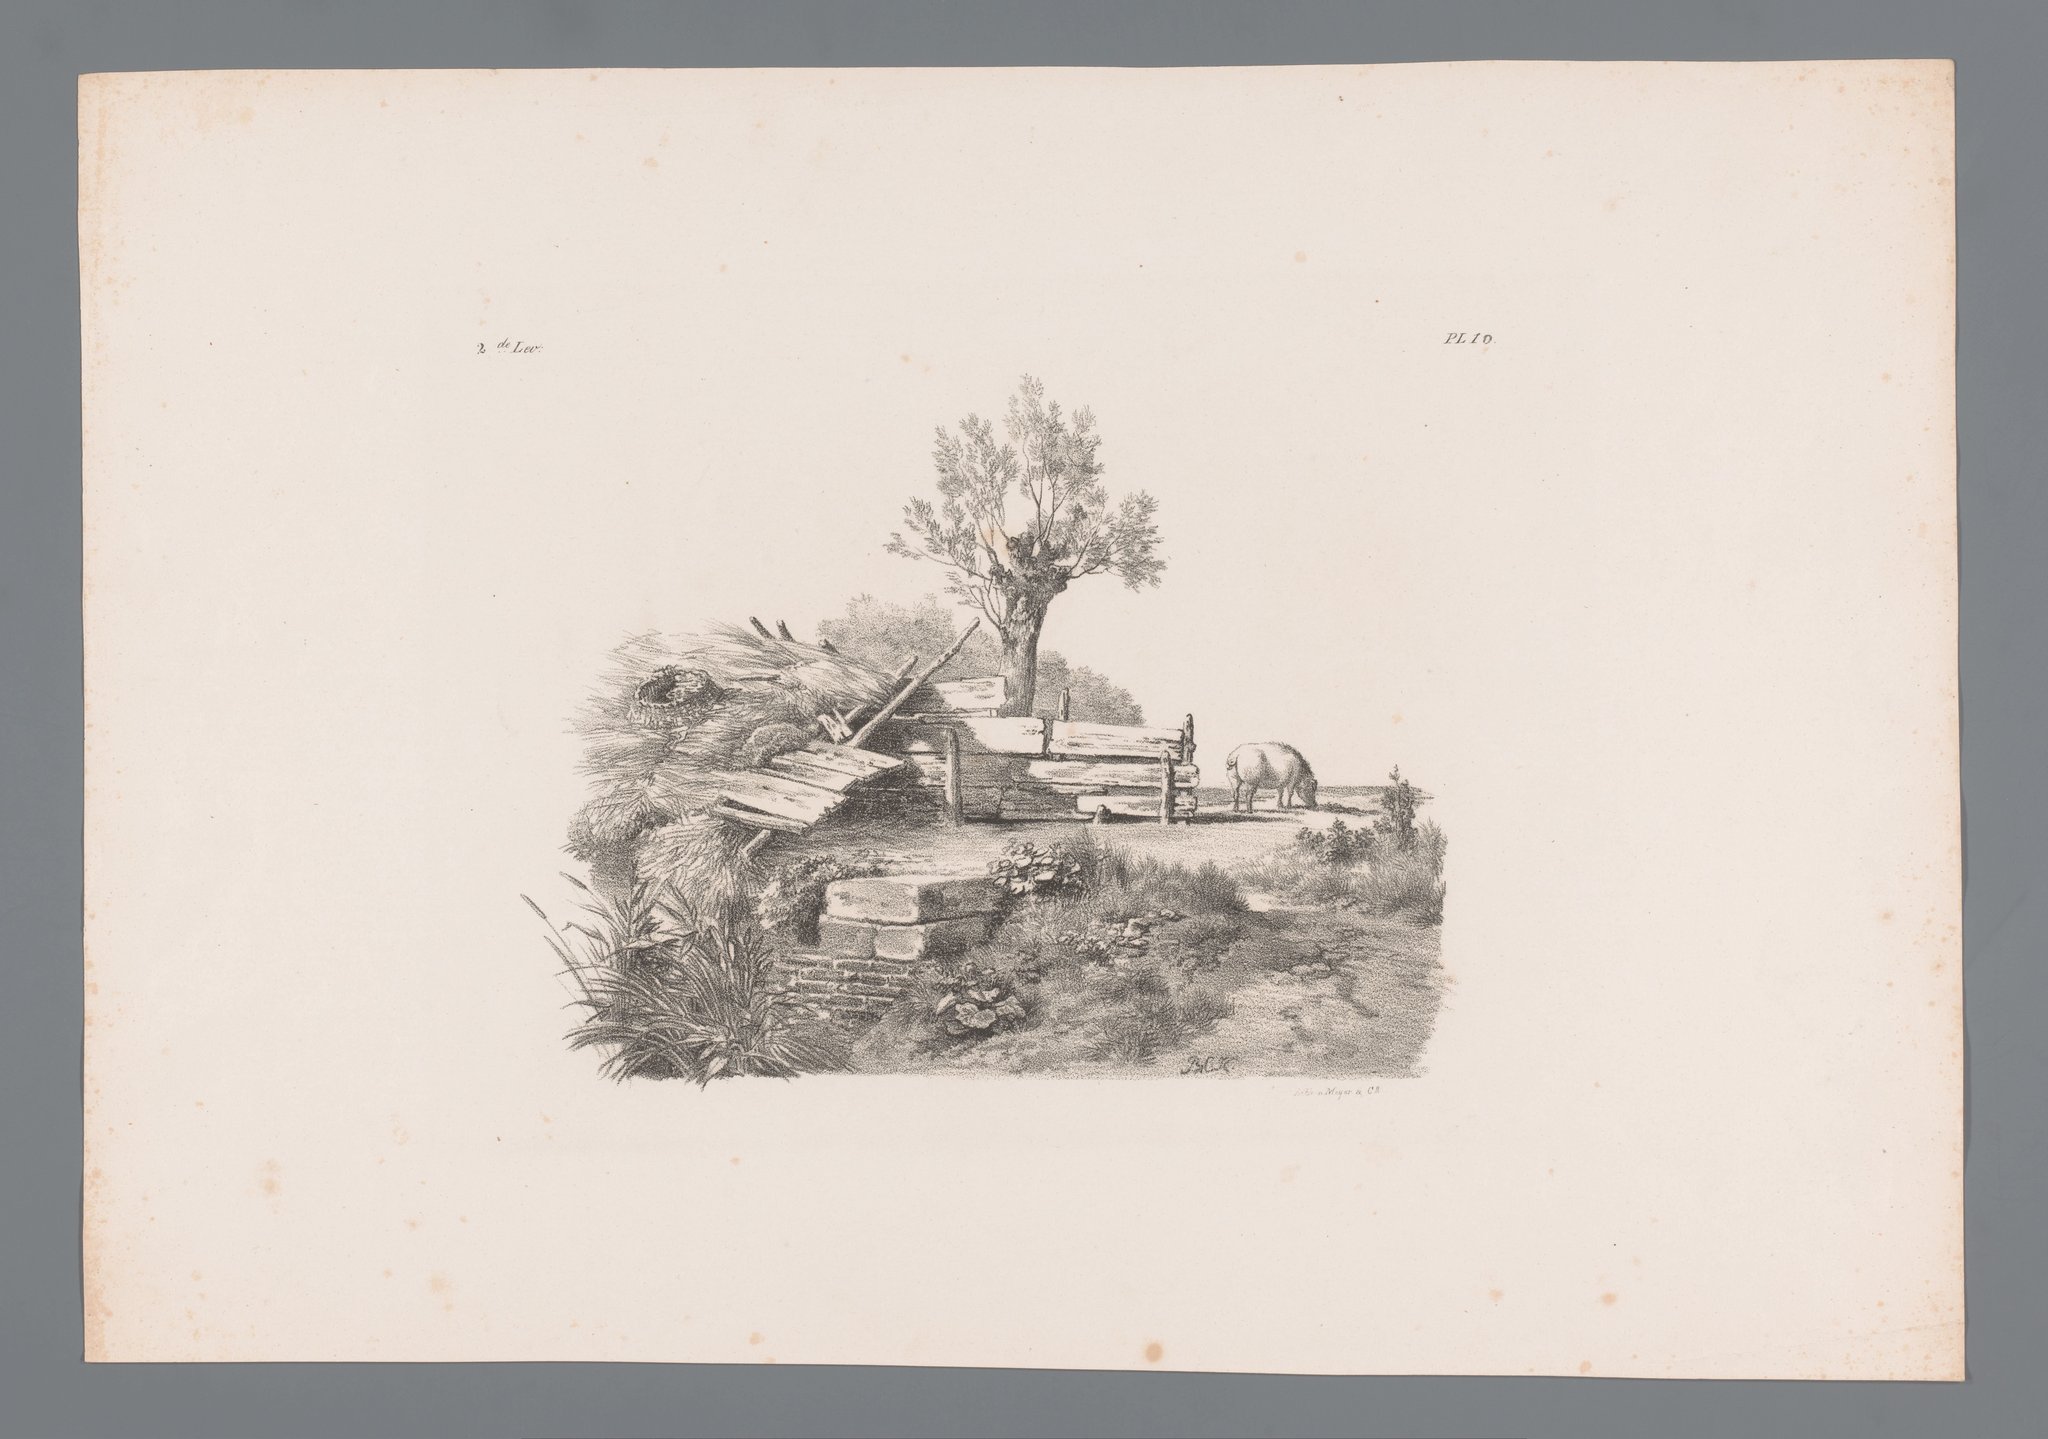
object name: print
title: Landschap studiën tweede levering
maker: barend cornelis koekkoek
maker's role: draughtsman, painter, print maker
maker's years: 1803-1862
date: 1844-1845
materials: paper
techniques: lithograph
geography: amsterdam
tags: pig, trees: willow, neglected dwelling, ruin of a dwelling, house, castle, etc.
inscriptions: collector's mark: Lugt 2228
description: In 1829 en 1830 gaf Koekkoek, samen met Daiwaille, zes cahiers uit met ieder zes prenten getiteld Landschapstudiën. Deze werden gebruikt in het tekenonderwijs. Vijftien jaar later werd deze reeks, in een andere samenstelling nogmaals uitgegeven door Meyer en Comp in Amsterdam. Zie: De Bruyn Kops, 1963.